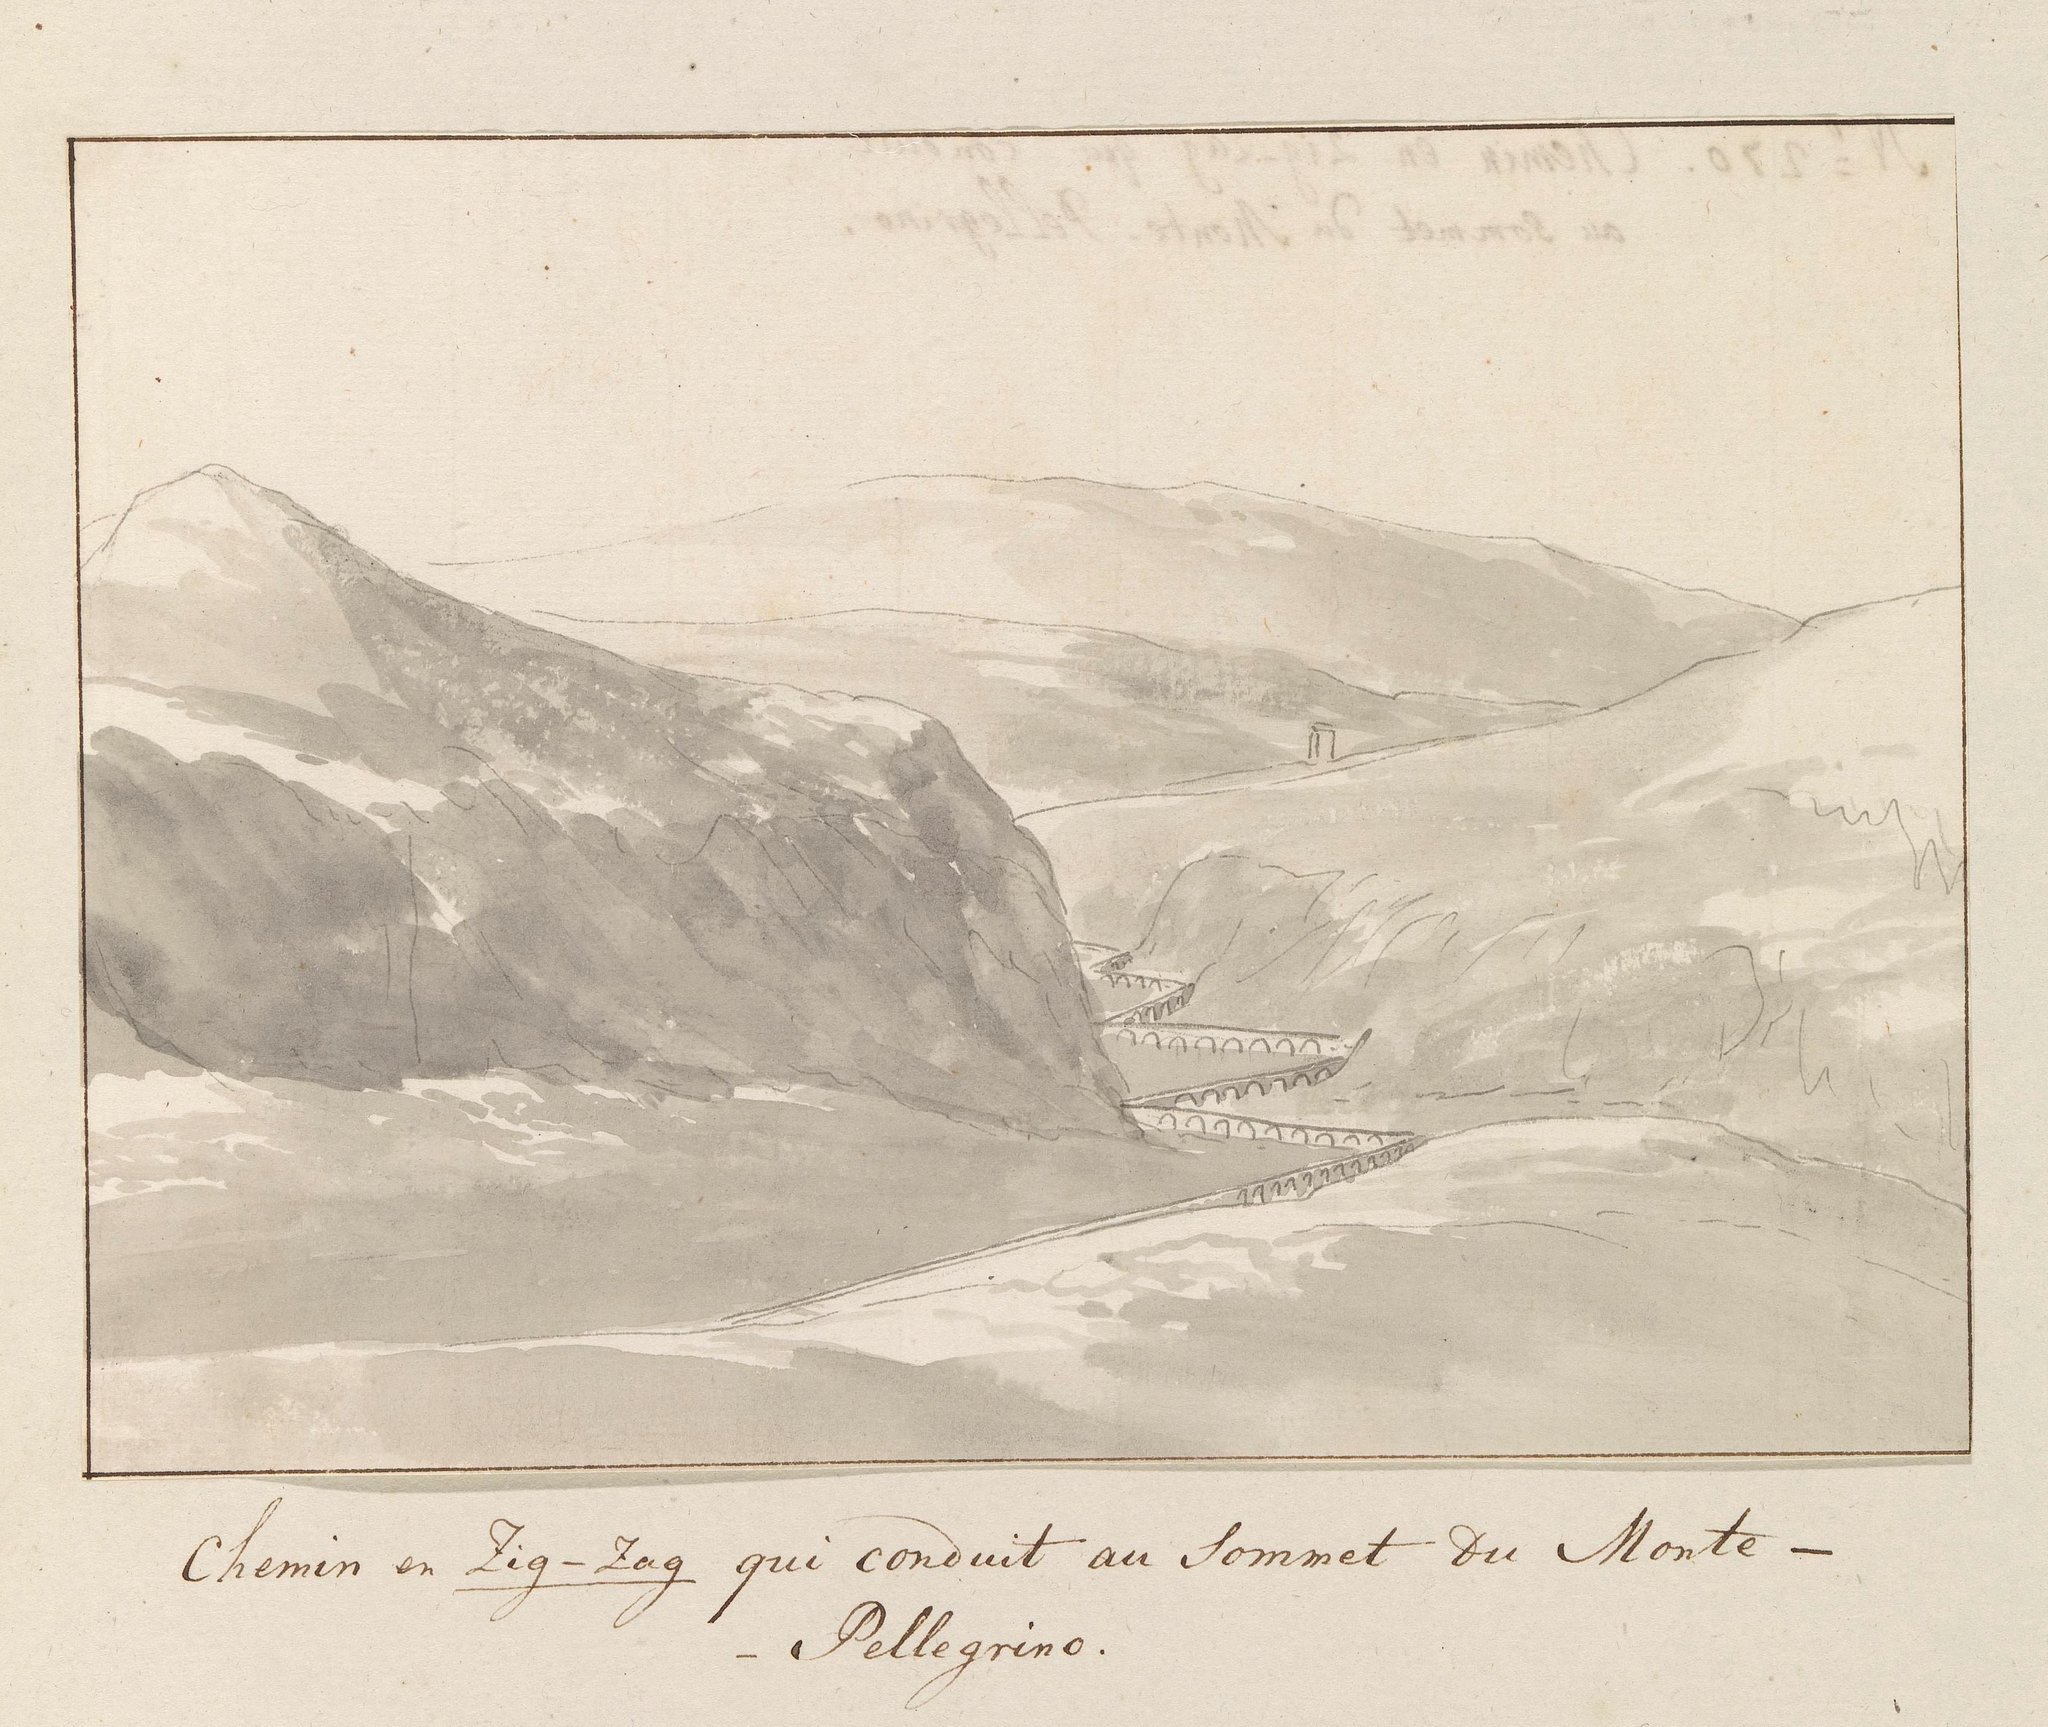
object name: drawing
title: Voyage en Italie, en Sicile et à Malte - 1778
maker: louis ducros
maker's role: draughtsman, print maker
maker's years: 1748-1810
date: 1778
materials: chalk, paper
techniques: brush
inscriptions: inscription: ‘No 270 Chemin en Zig-Zag qui conduit au sommet du Monte-Pellegrino’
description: Tekening uit het album 'Voyage en Italie, en Sicile et à Malte', 1778.